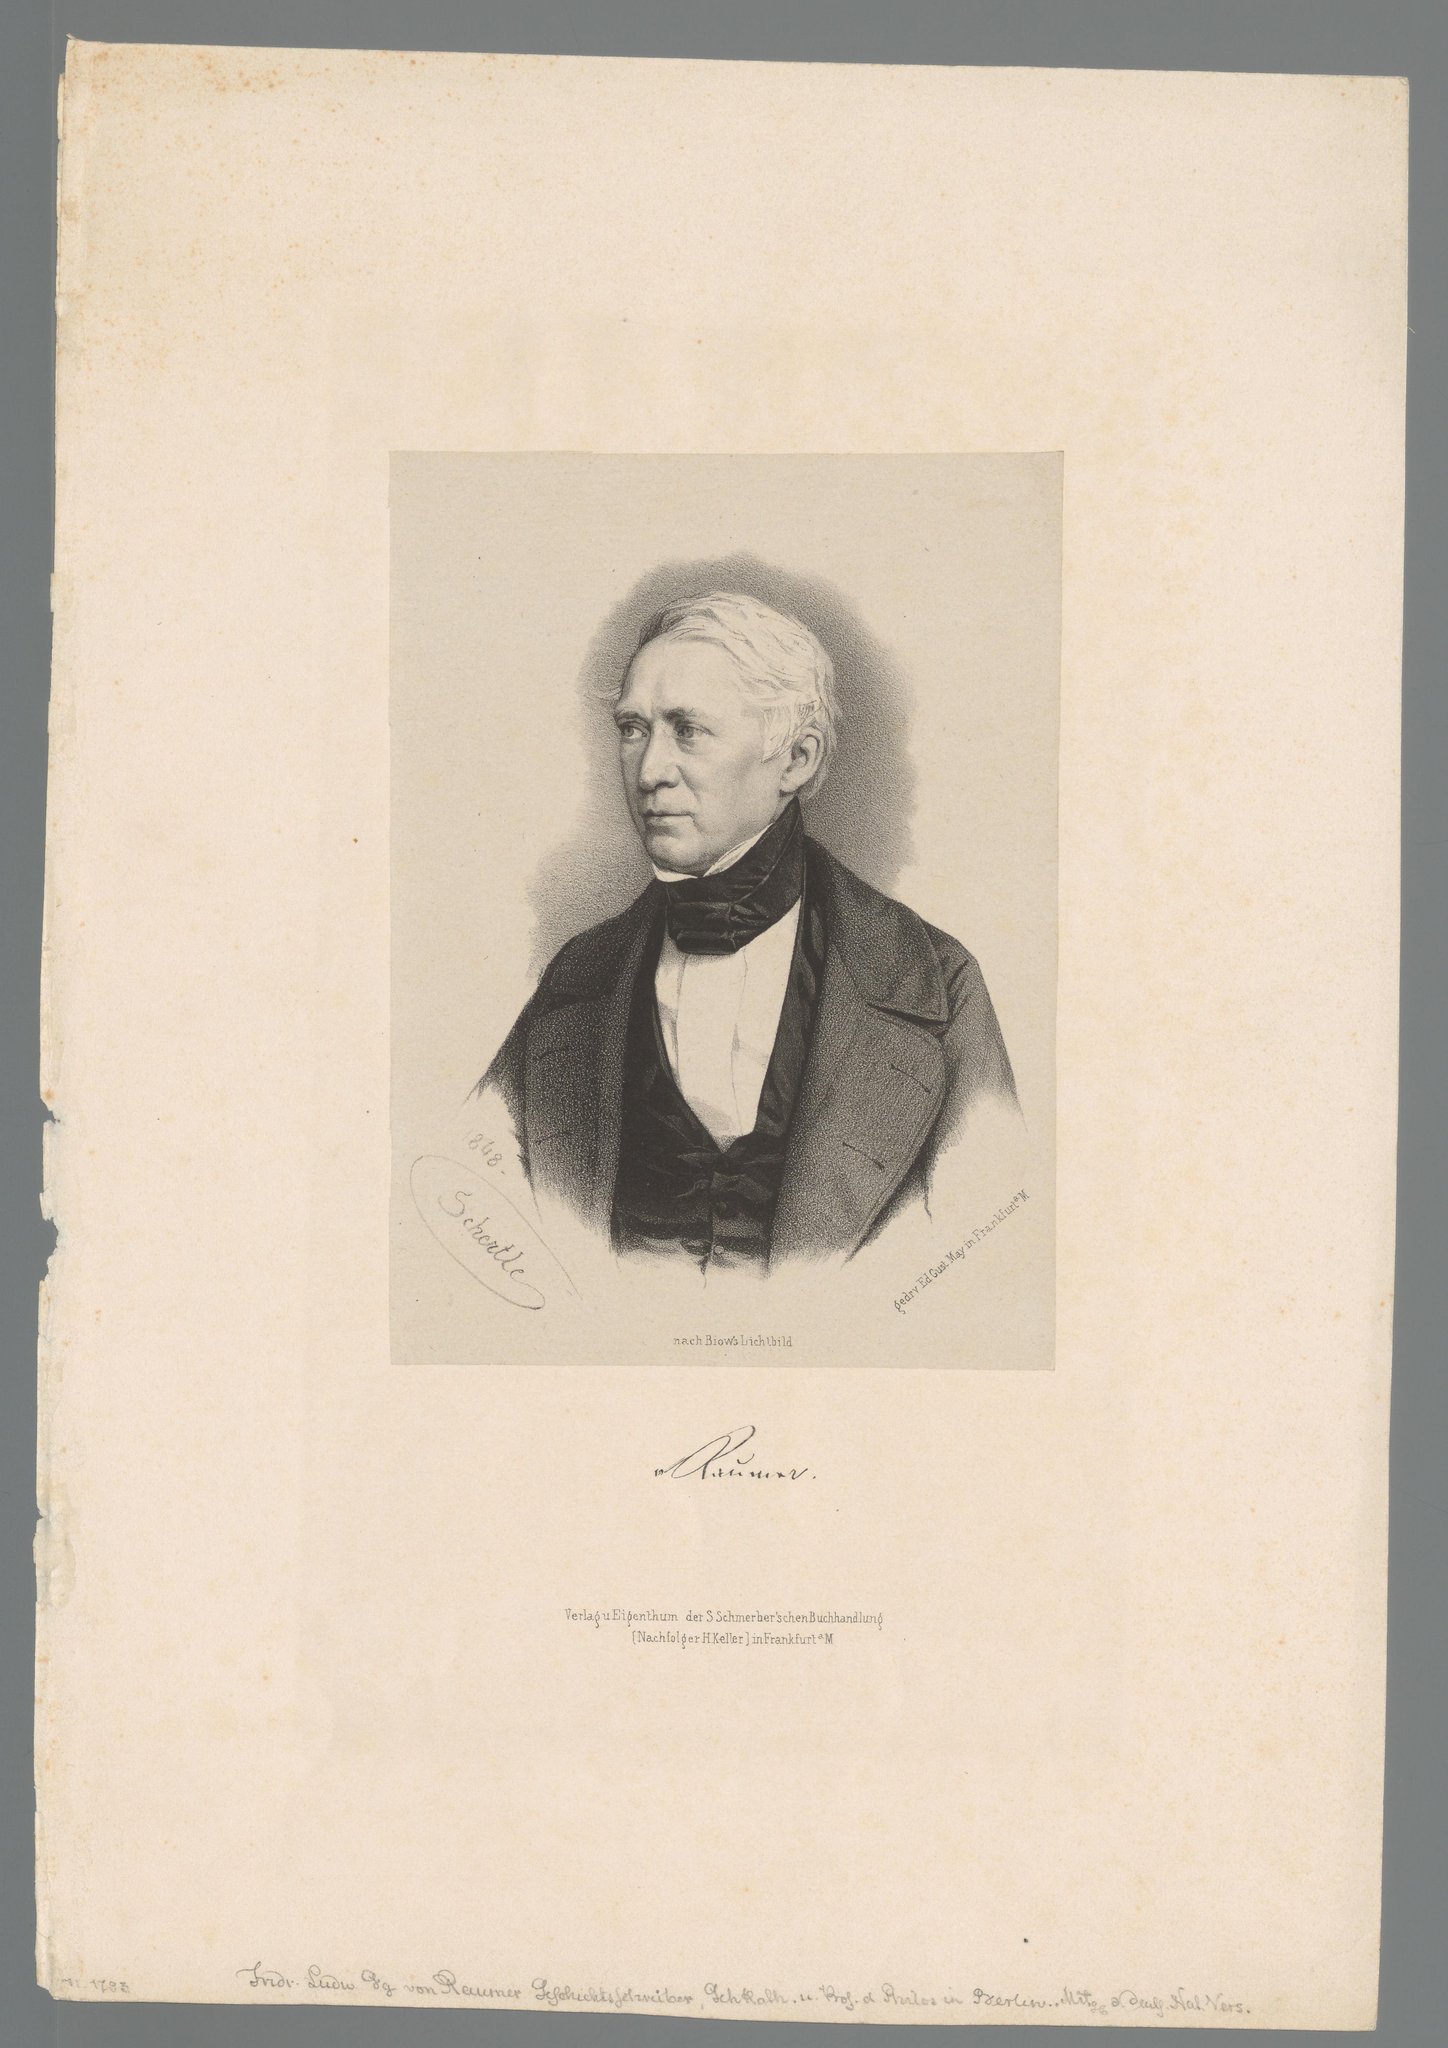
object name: print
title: Portretten van Duitse mannen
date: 1848-1849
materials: paper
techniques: lithograph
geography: frankfurt am main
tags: friedrich von raumer, adult man, historical persons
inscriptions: collector's mark: Lugt 2228